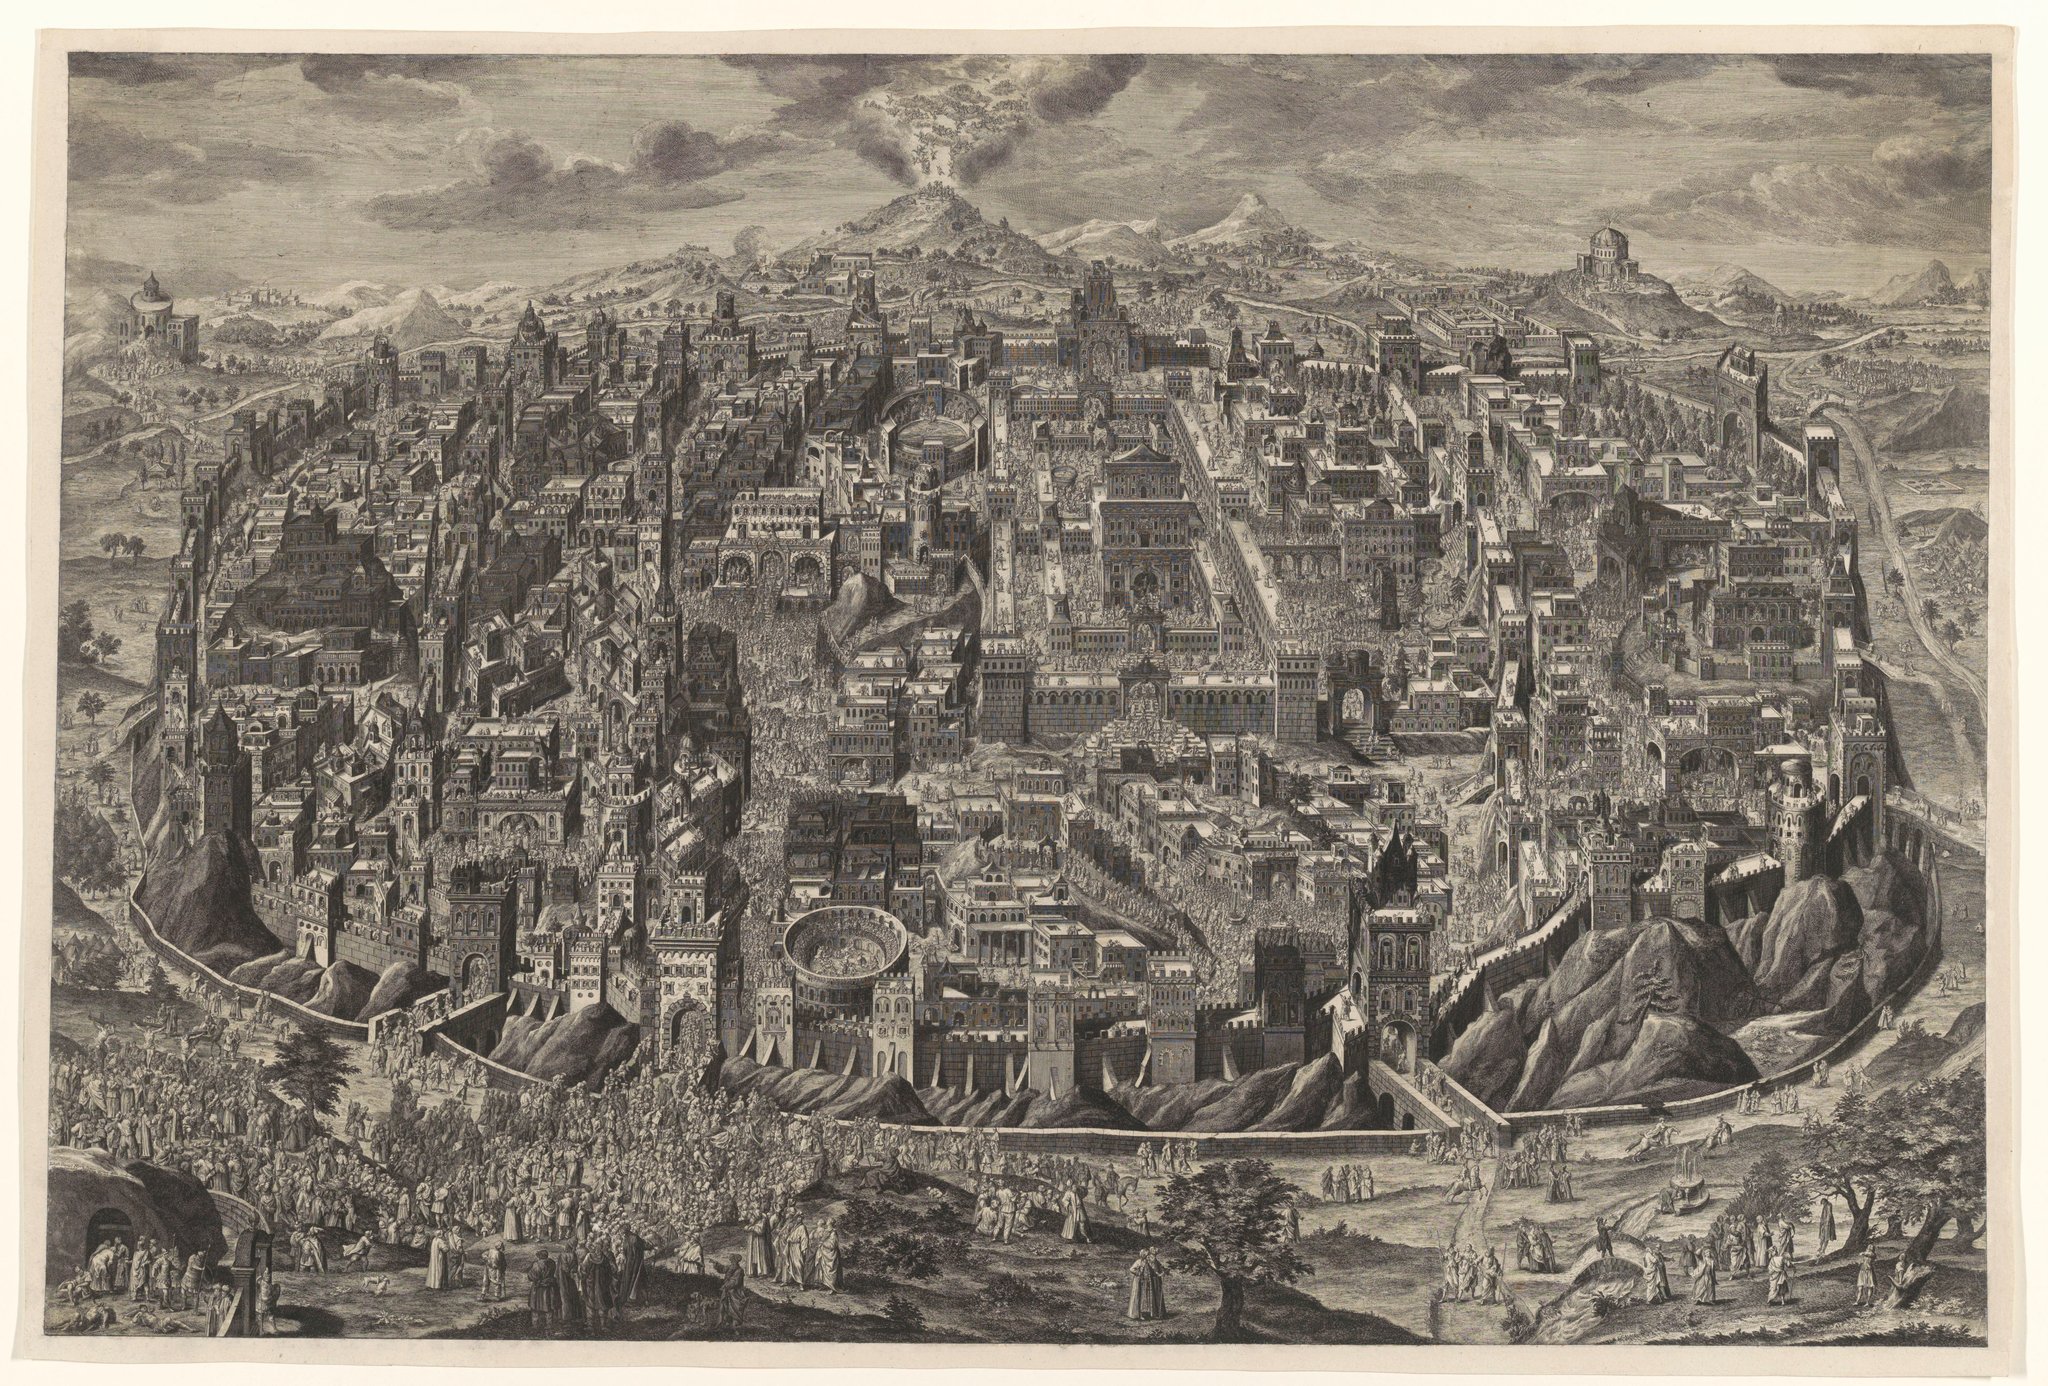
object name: print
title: Overzichtskaart in vogelvlucht perspectief van Jeruzalem met voorstellingen van Christus’ Passie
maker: johann daniel herz (i)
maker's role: print maker, publisher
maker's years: 1693-1754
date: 1735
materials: paper, wood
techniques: engraving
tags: map with jerusalem as centre, passion of christ